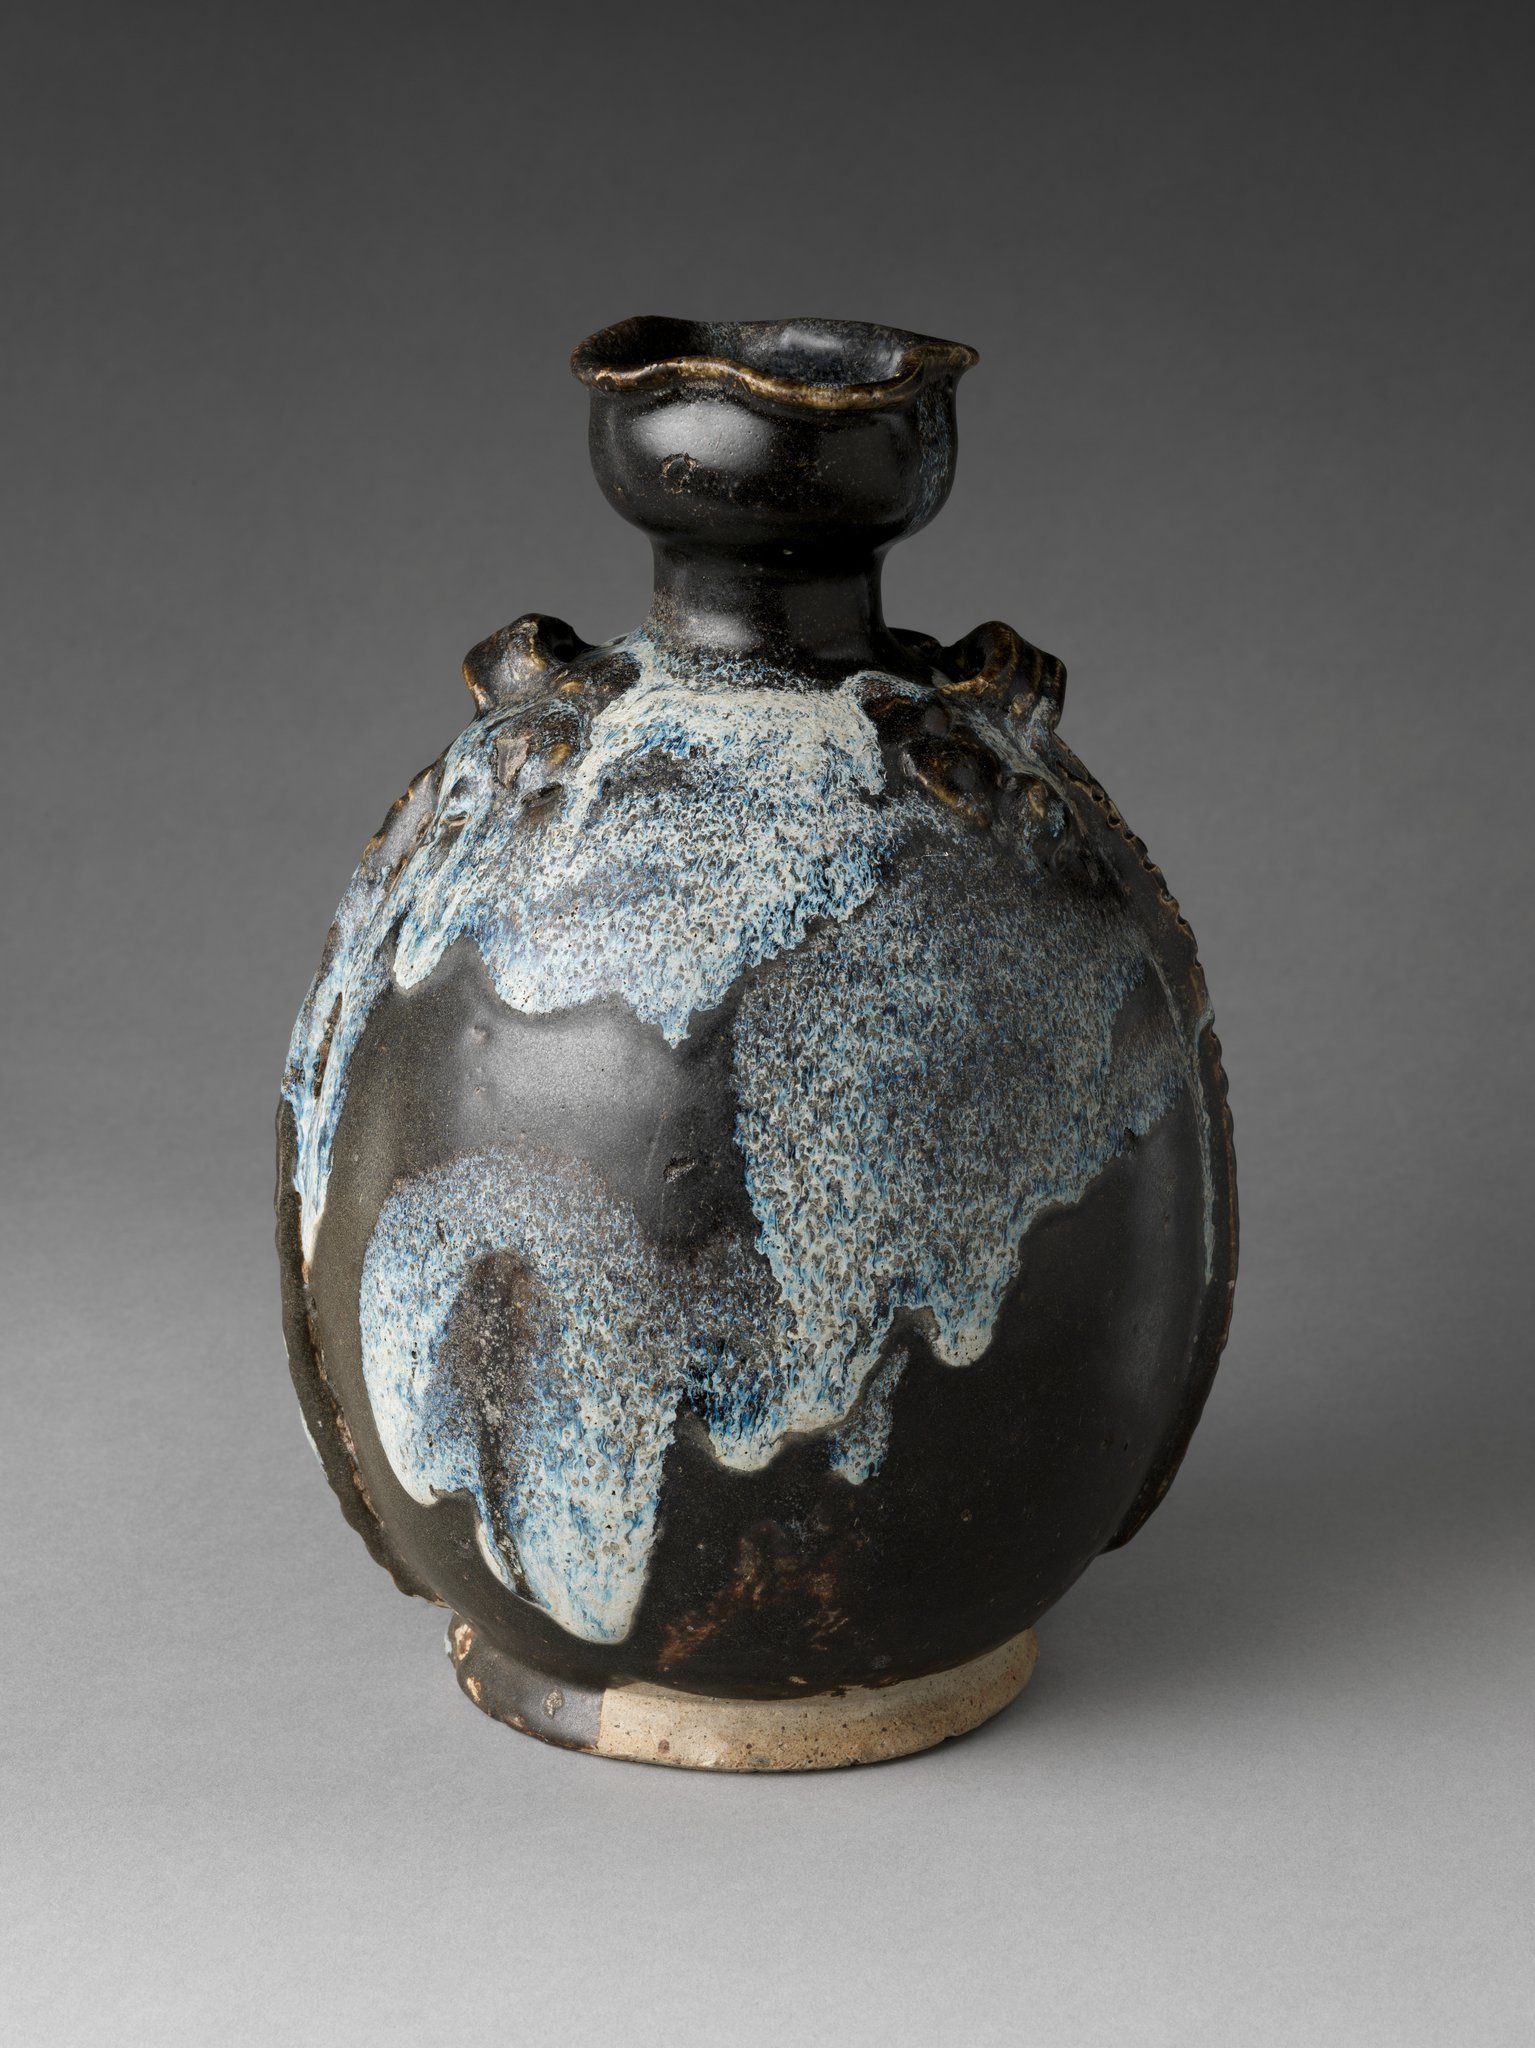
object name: flask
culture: chinese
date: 801-900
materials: glaze, stoneware